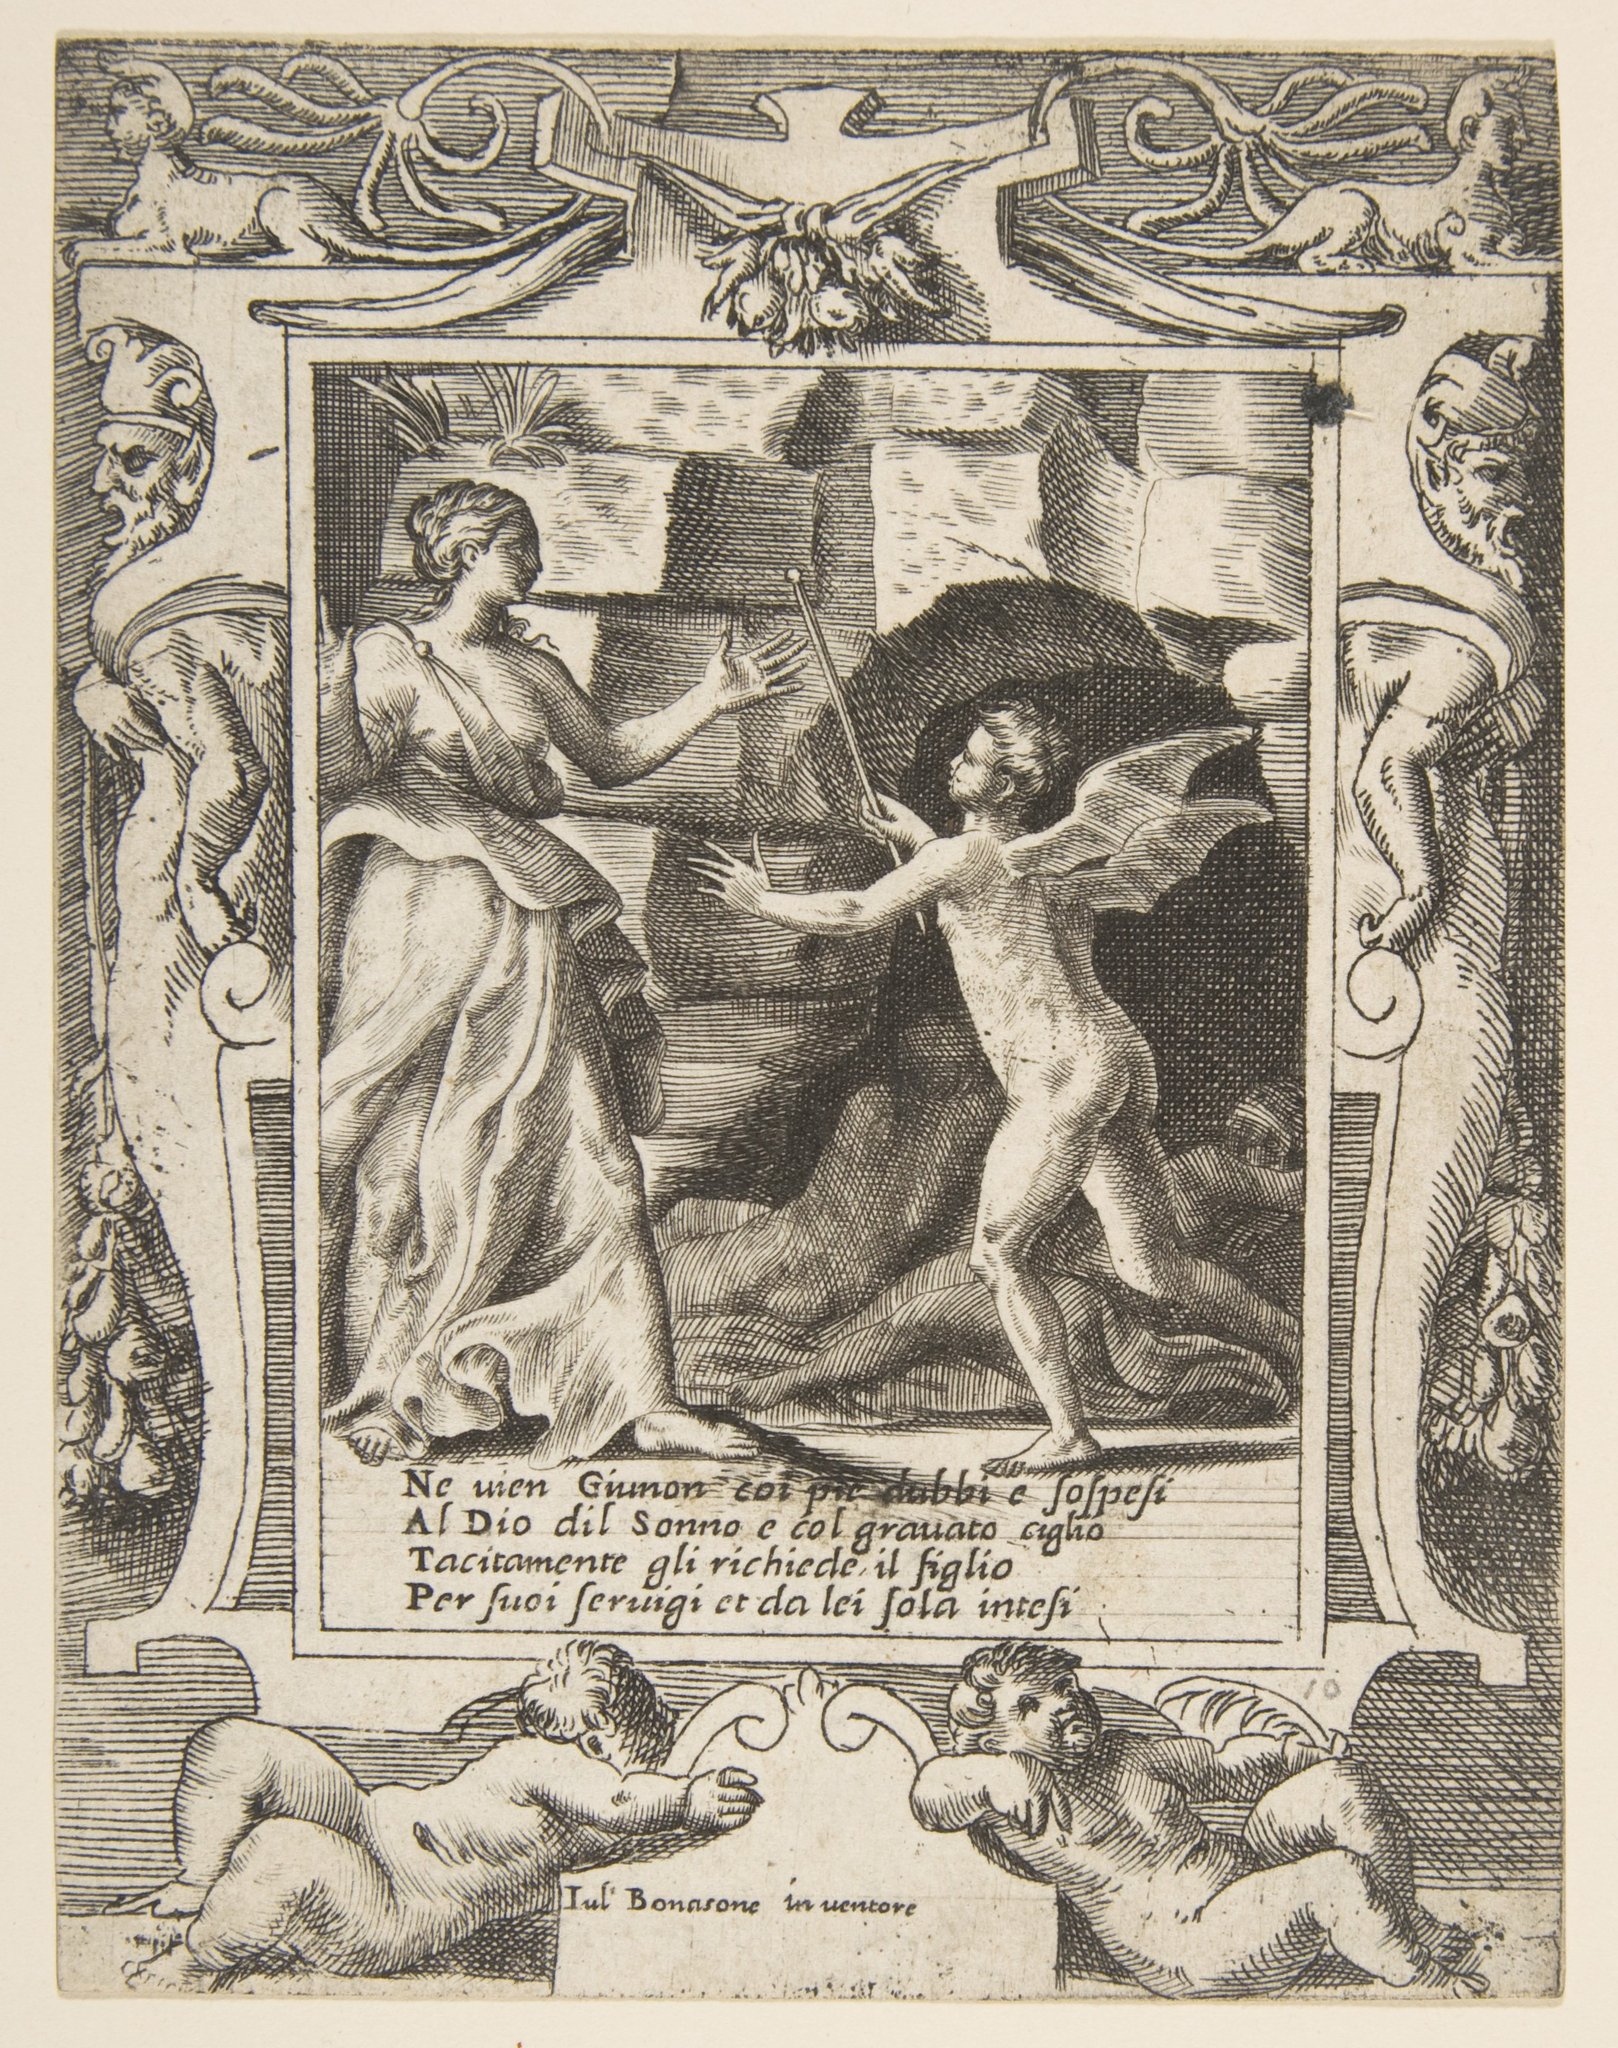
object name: print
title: Juno summoning sleep to descend upon Jupiter, set within an elaborate frame, from "Loves, Rages and Jealousies of Juno"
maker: giulio bonasone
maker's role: artist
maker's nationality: italian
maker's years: 1510-1576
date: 1531-1576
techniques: engraving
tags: juno,jupiter